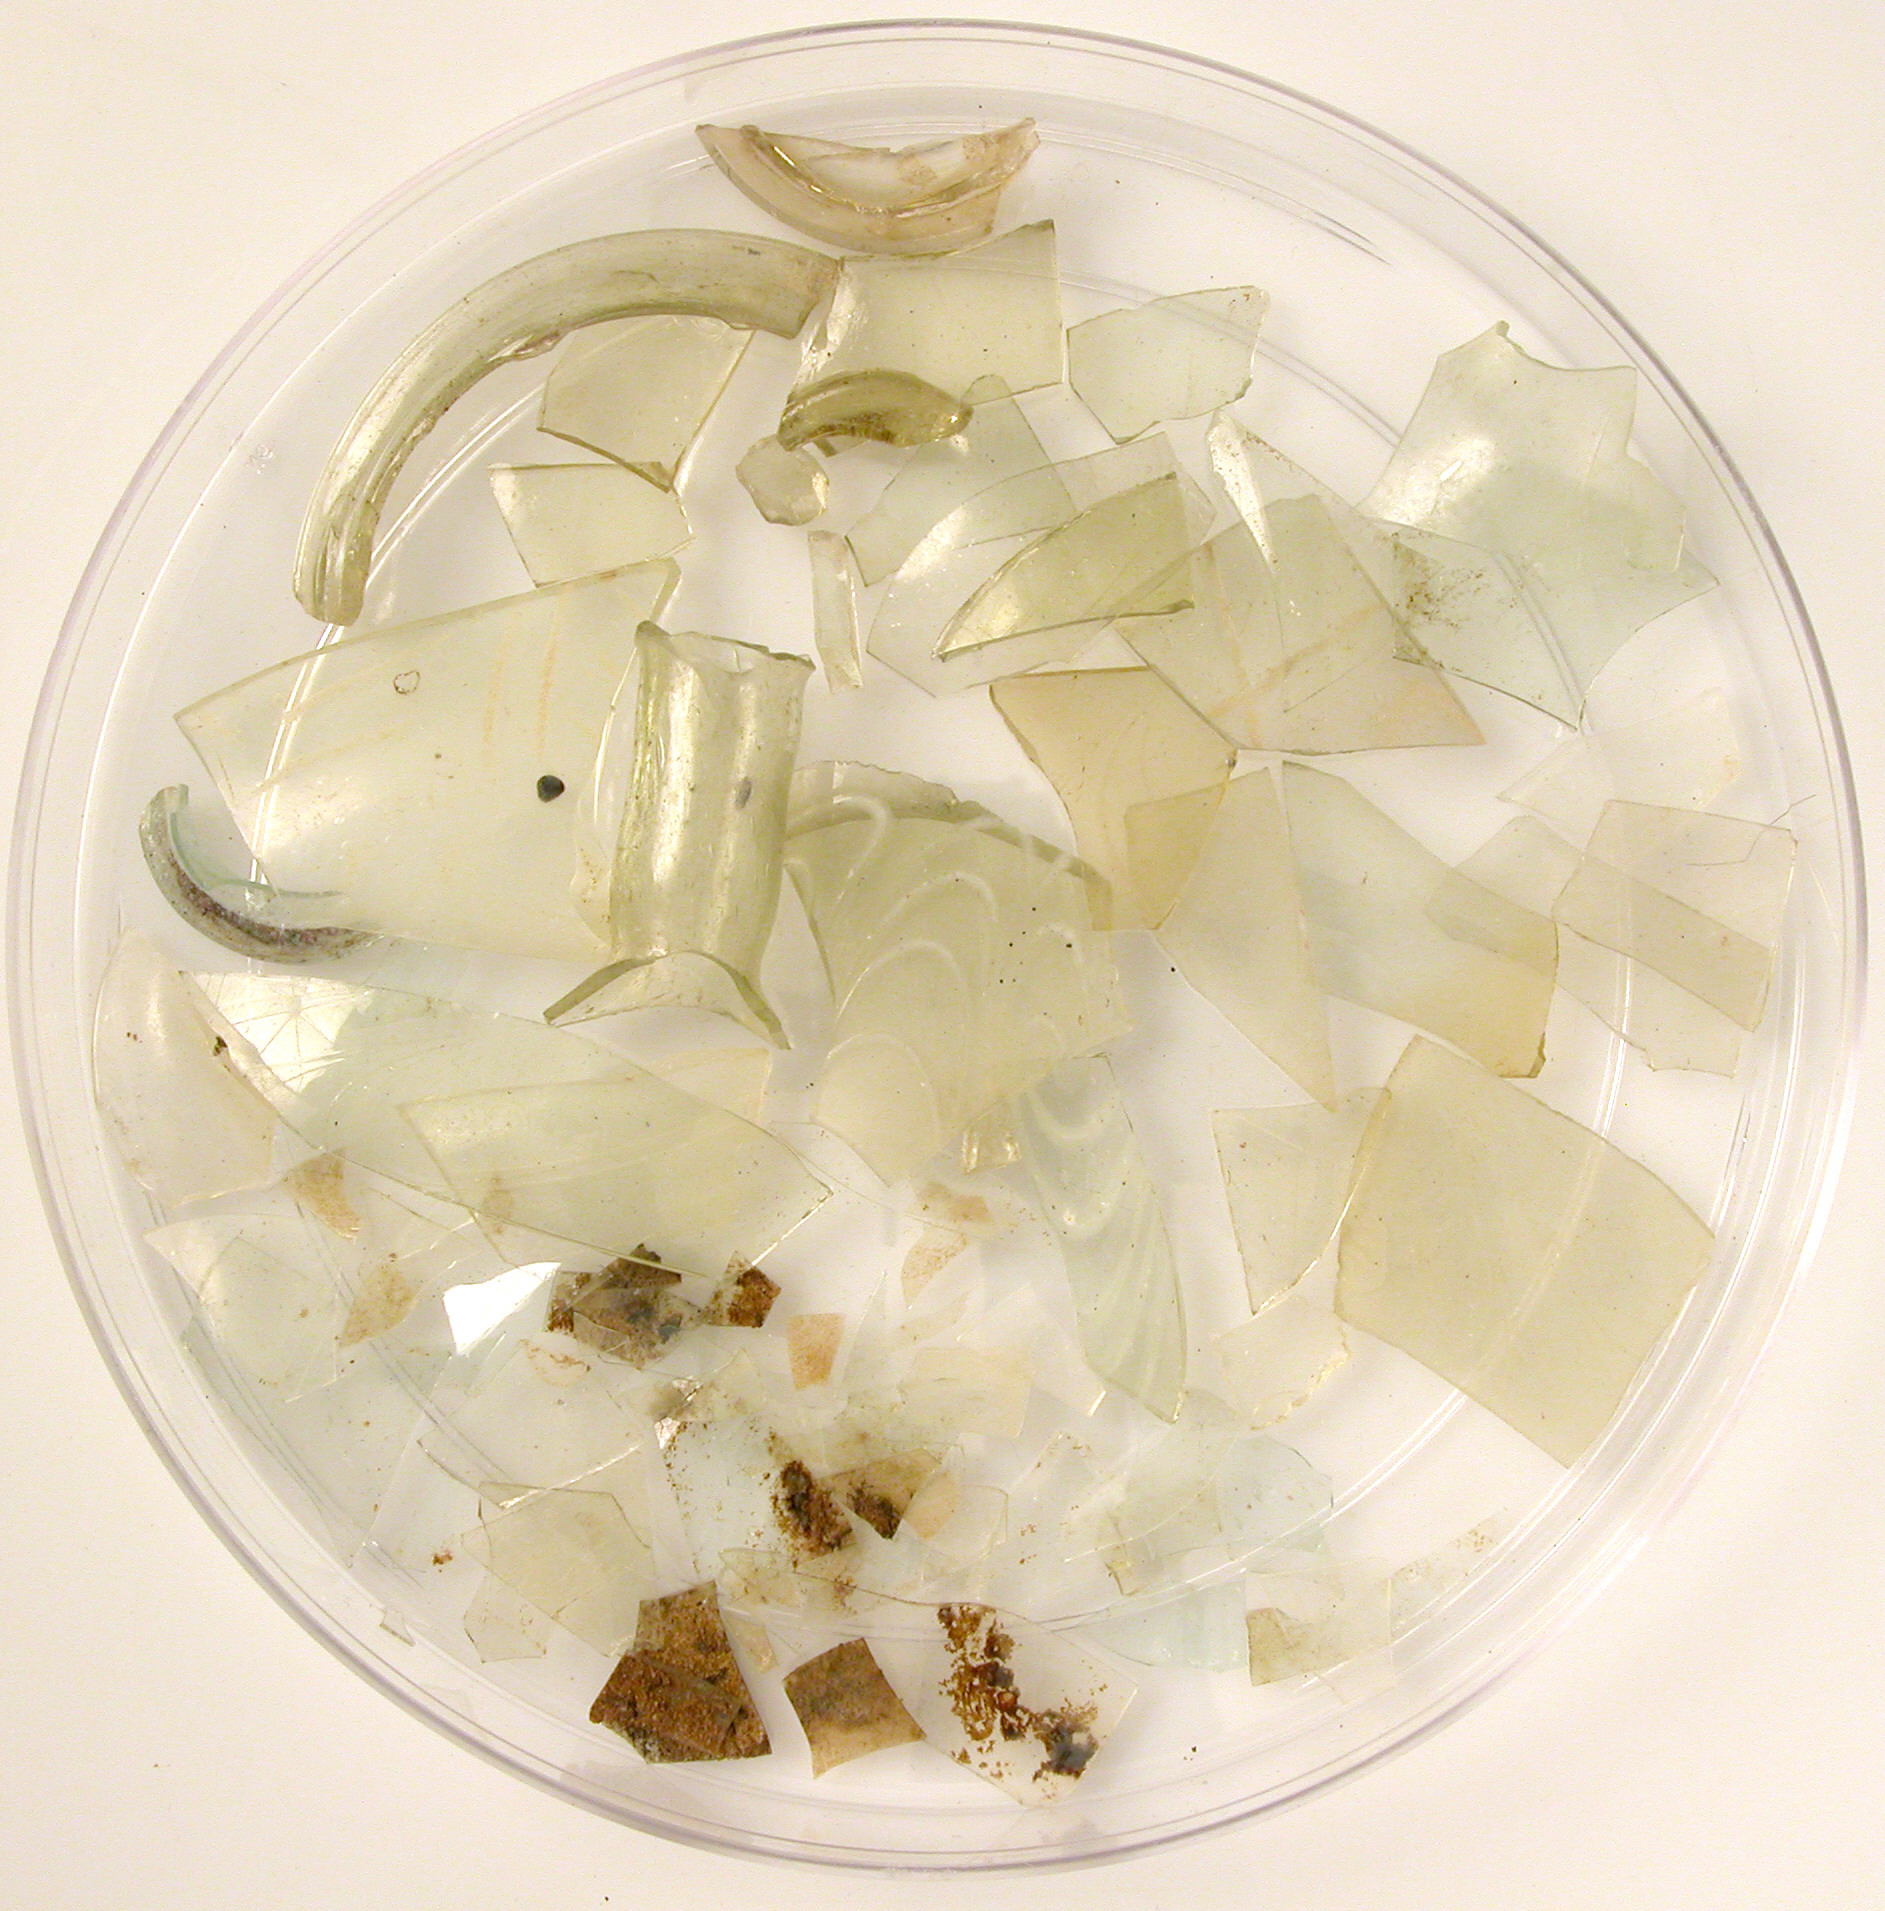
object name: fragment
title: Glass Fragments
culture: coptic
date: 301-700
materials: glass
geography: egypt